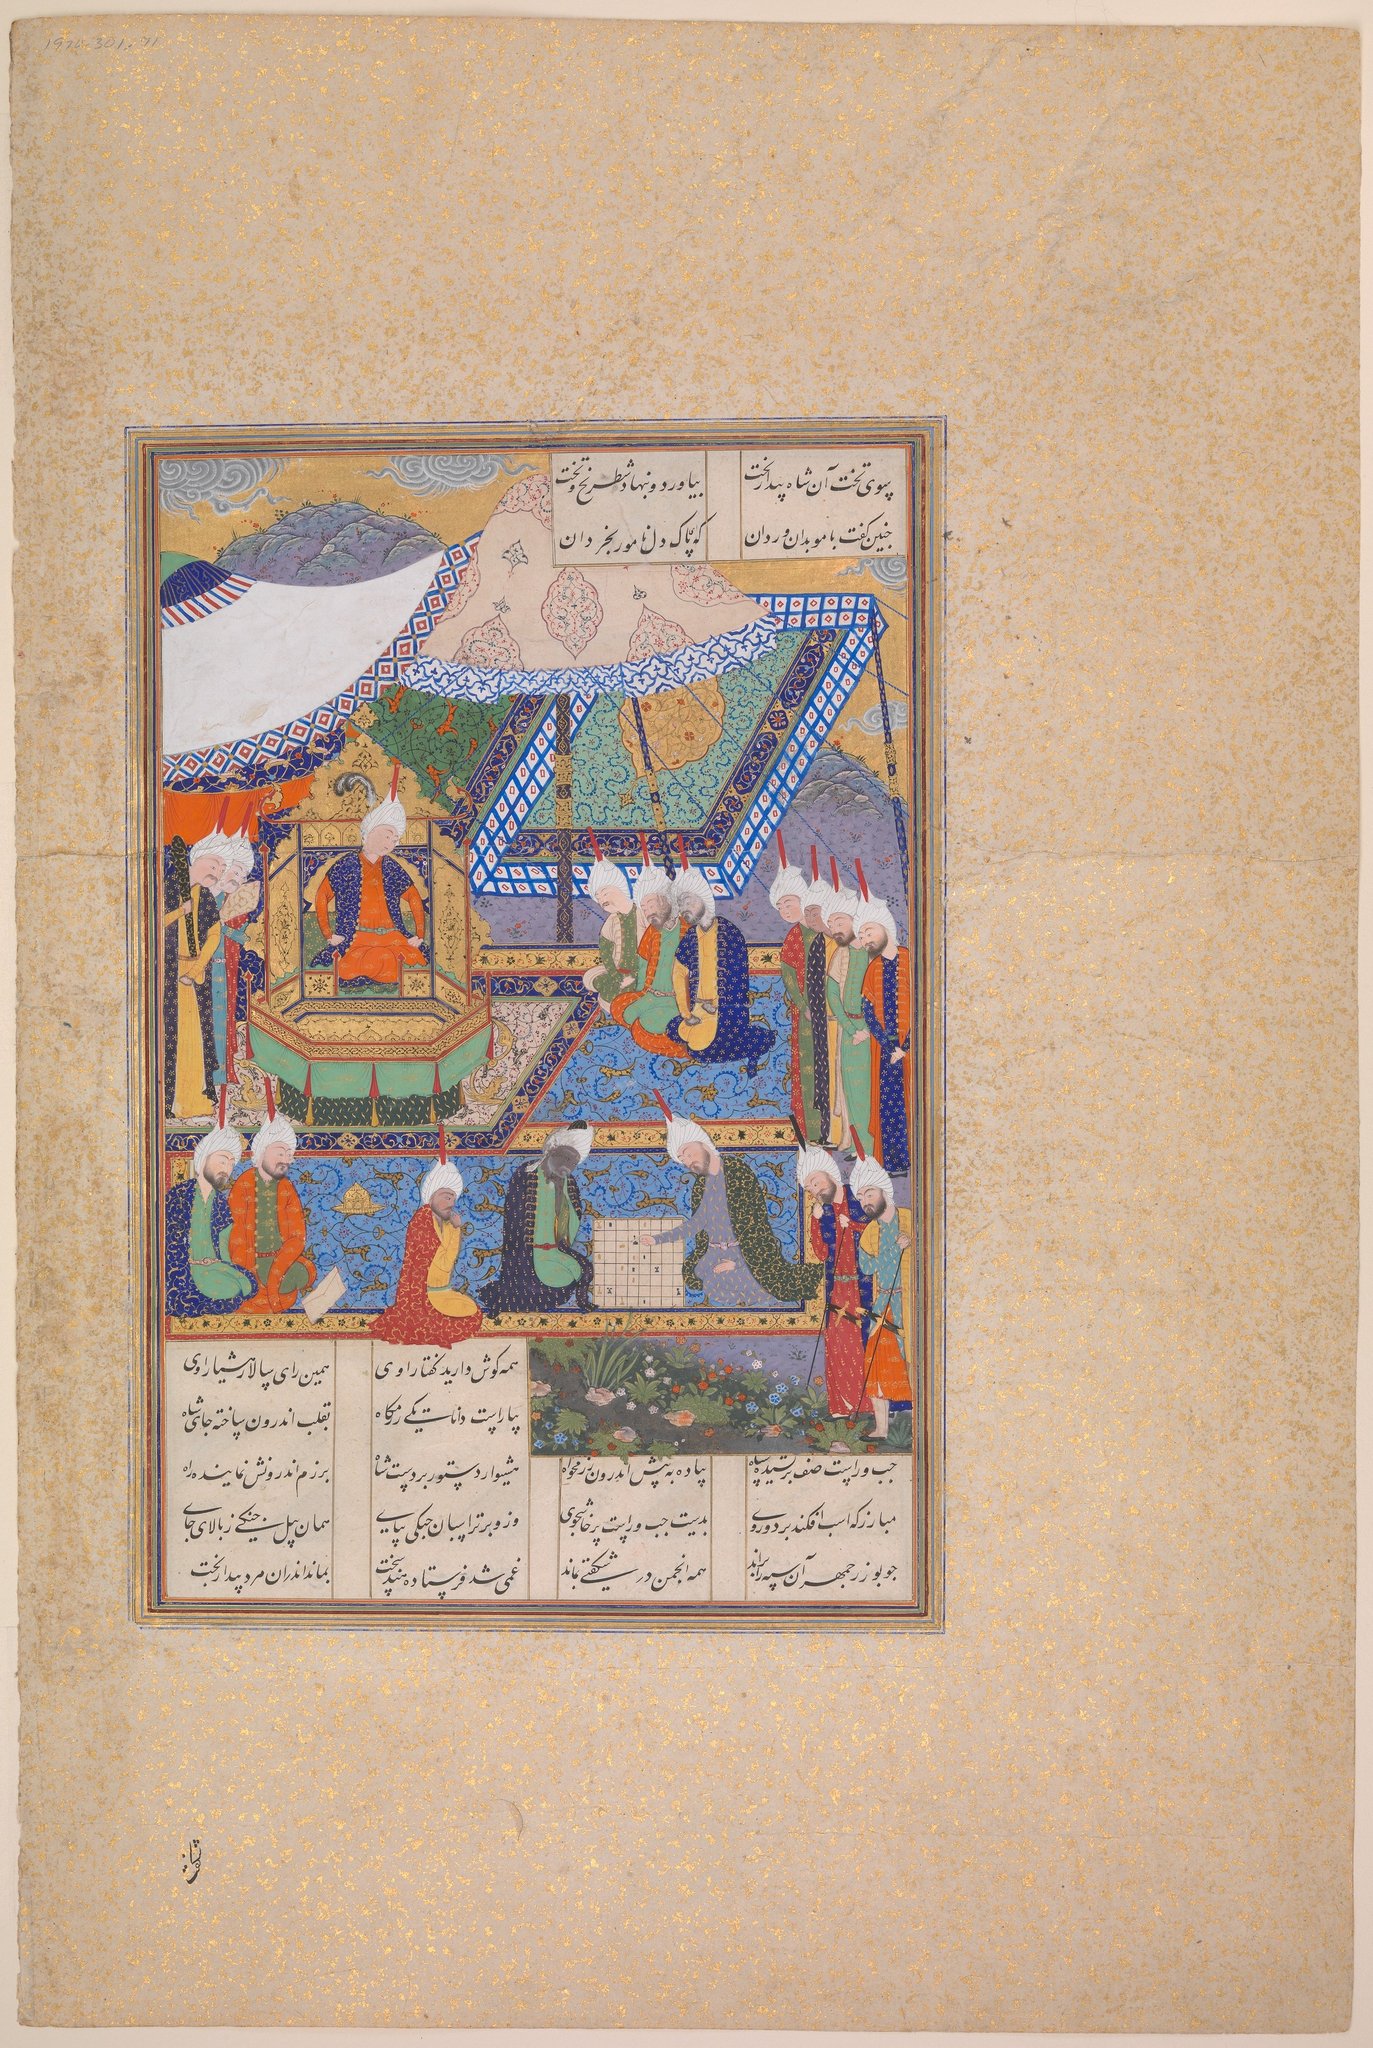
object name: folio from an illustrated manuscript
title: "Buzurjmihr Masters the Hindu Game of Chess", Folio 639v from the Shahnama (Book of Kings) of Shah Tahmasp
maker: abu'l qasim firdausi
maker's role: author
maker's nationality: iranian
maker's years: 935-1020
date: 1530-1535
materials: gold, ink, paper, silver, watercolor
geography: iran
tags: kings,men,chess